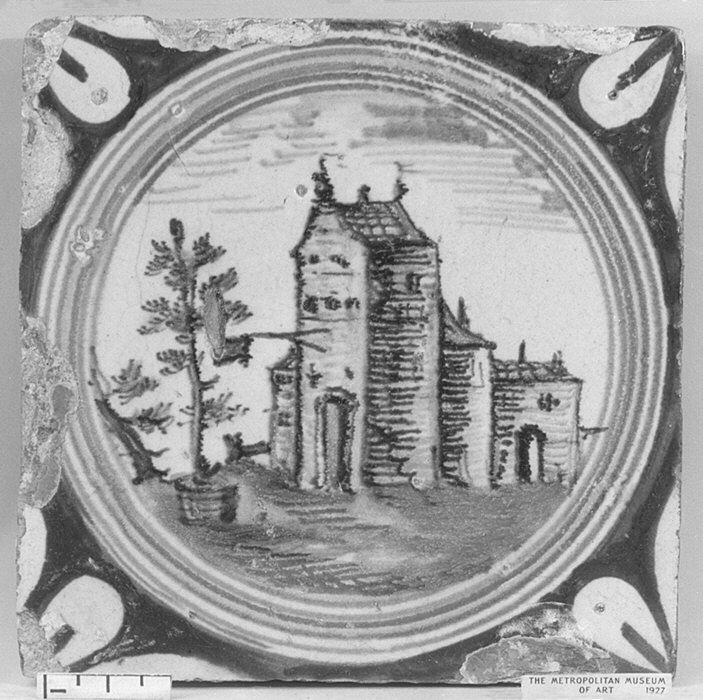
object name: tile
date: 1580-1625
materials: earthenware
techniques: glazing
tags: houses,trees